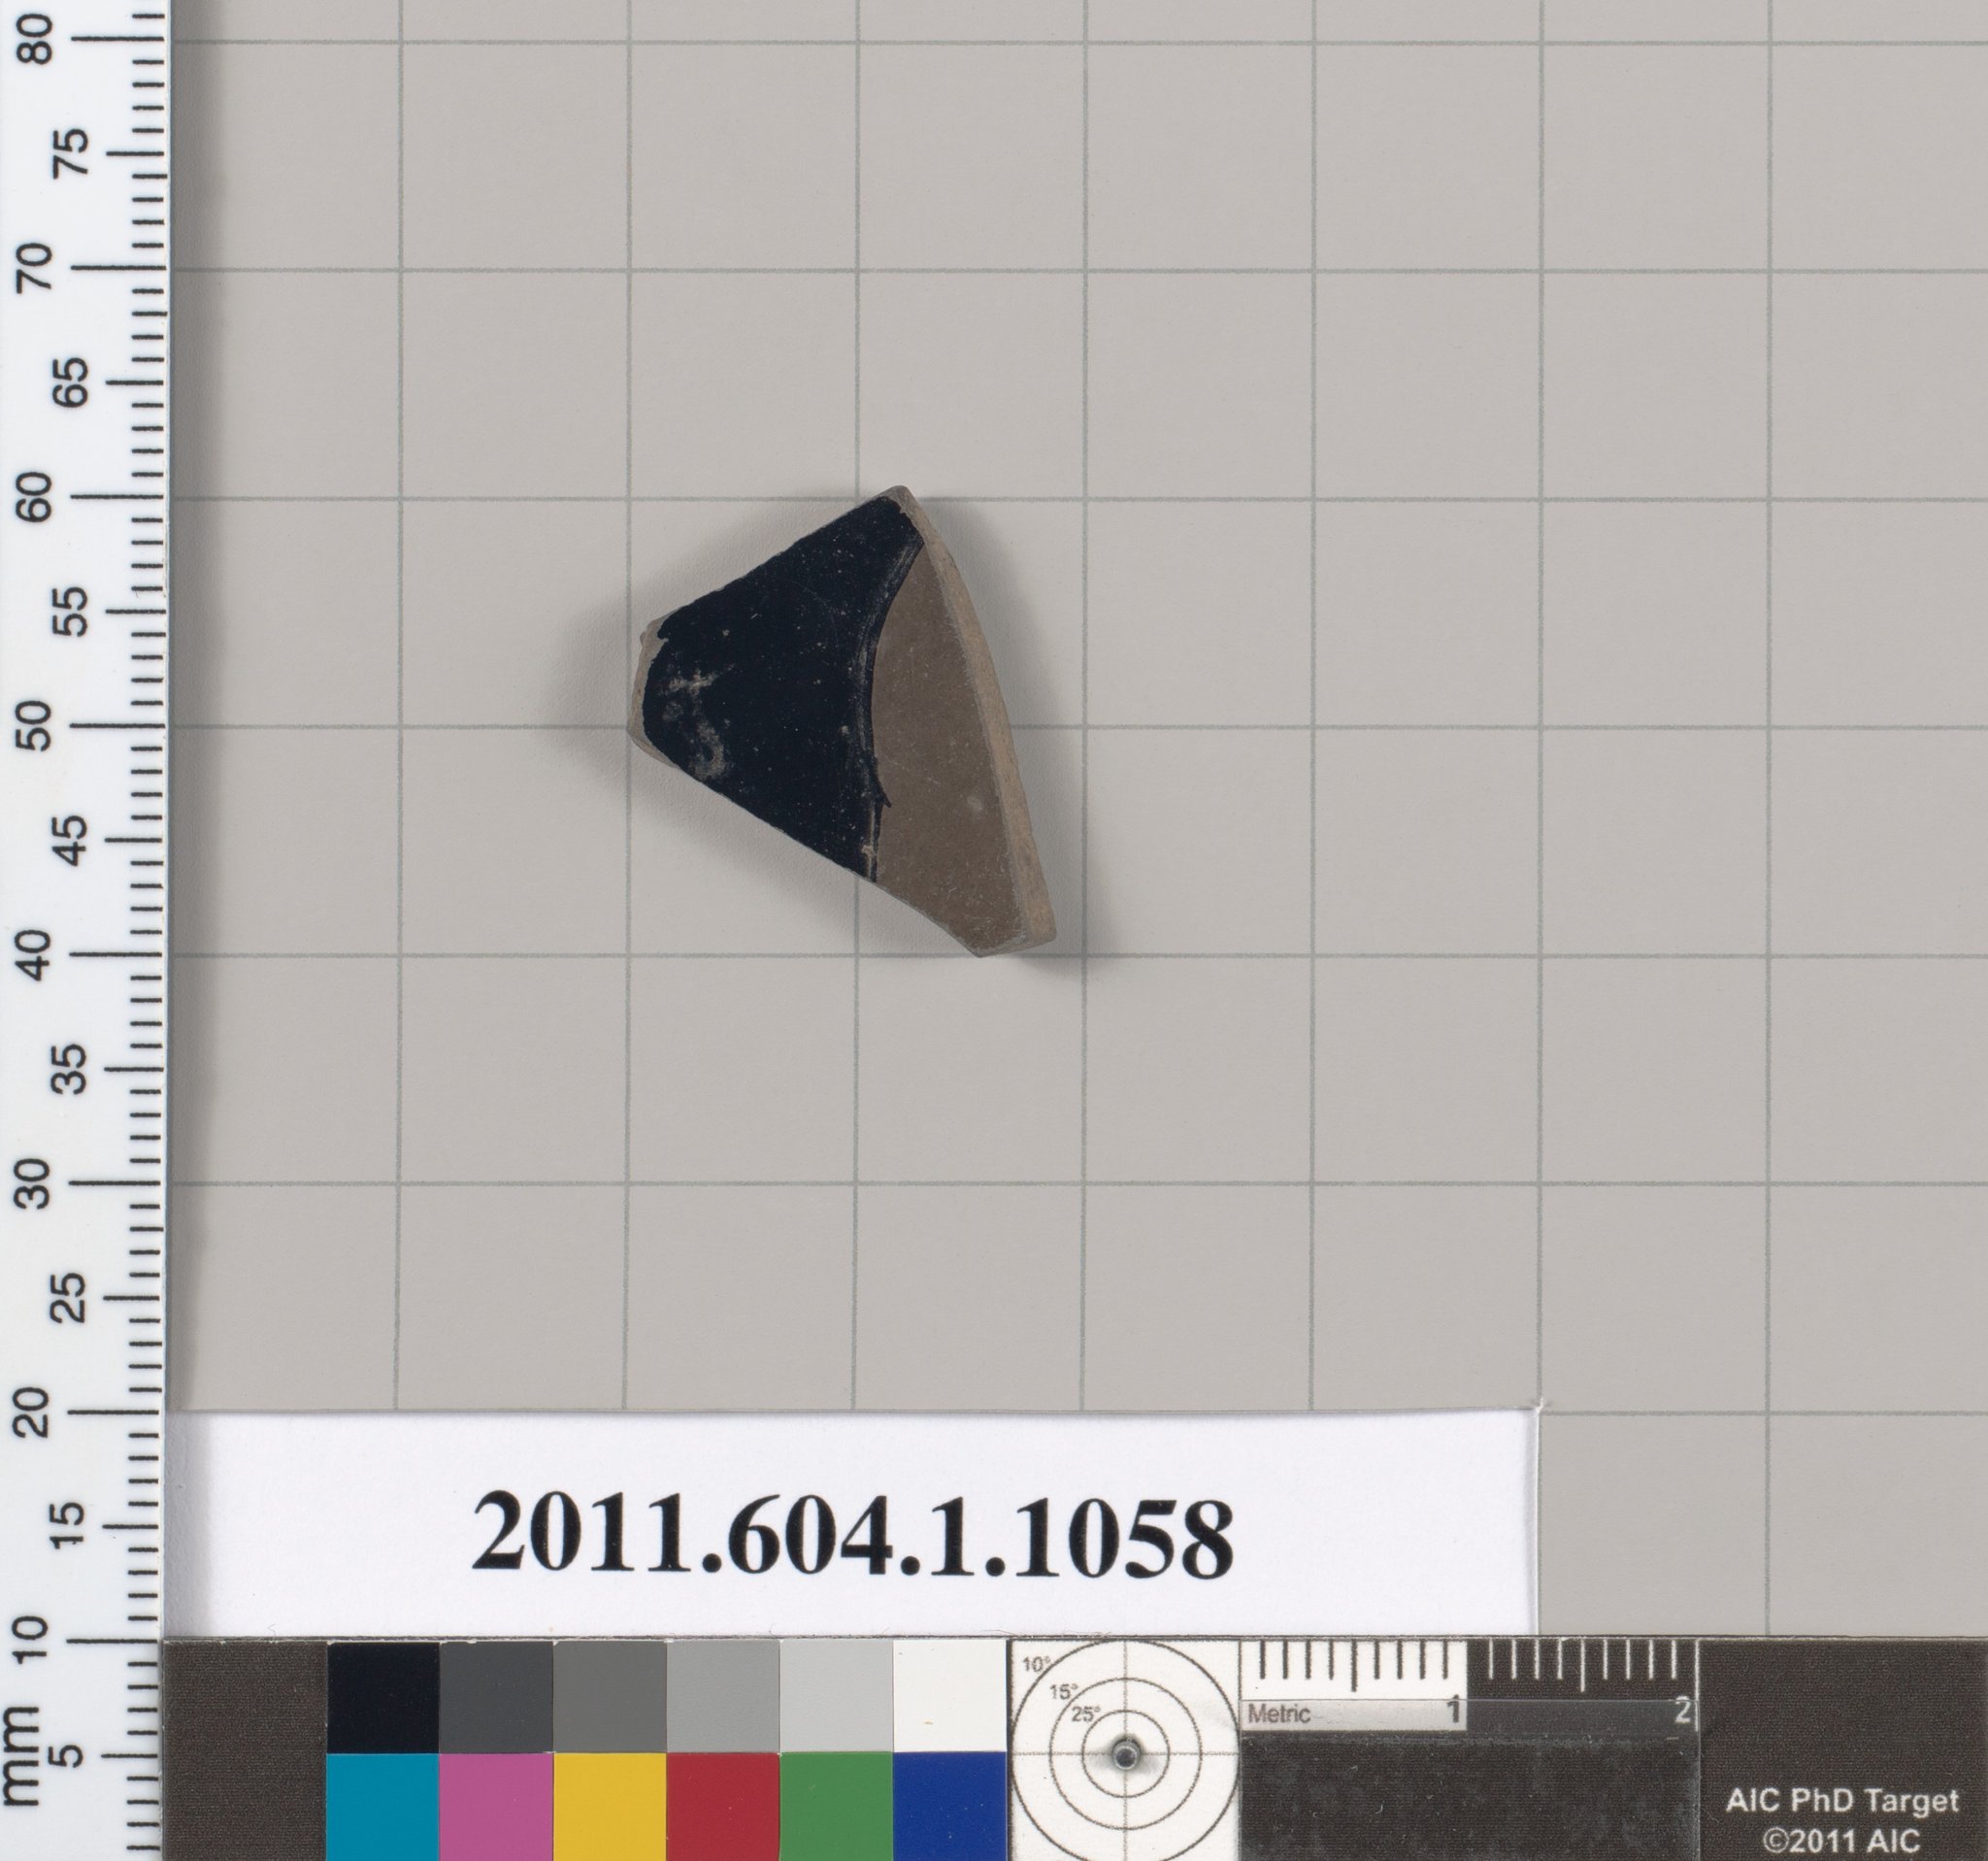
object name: kylix fragment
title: Terracotta fragment of a kylix (drinking cup)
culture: greek, attic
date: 475-451 BCE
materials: terracotta